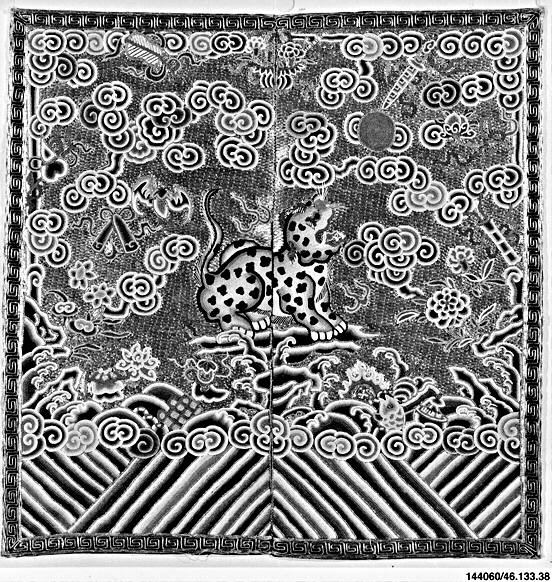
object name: rank badge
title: Rank Badge with Leopard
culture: chinese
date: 1801-1900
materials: gold, silk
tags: bats,leopards